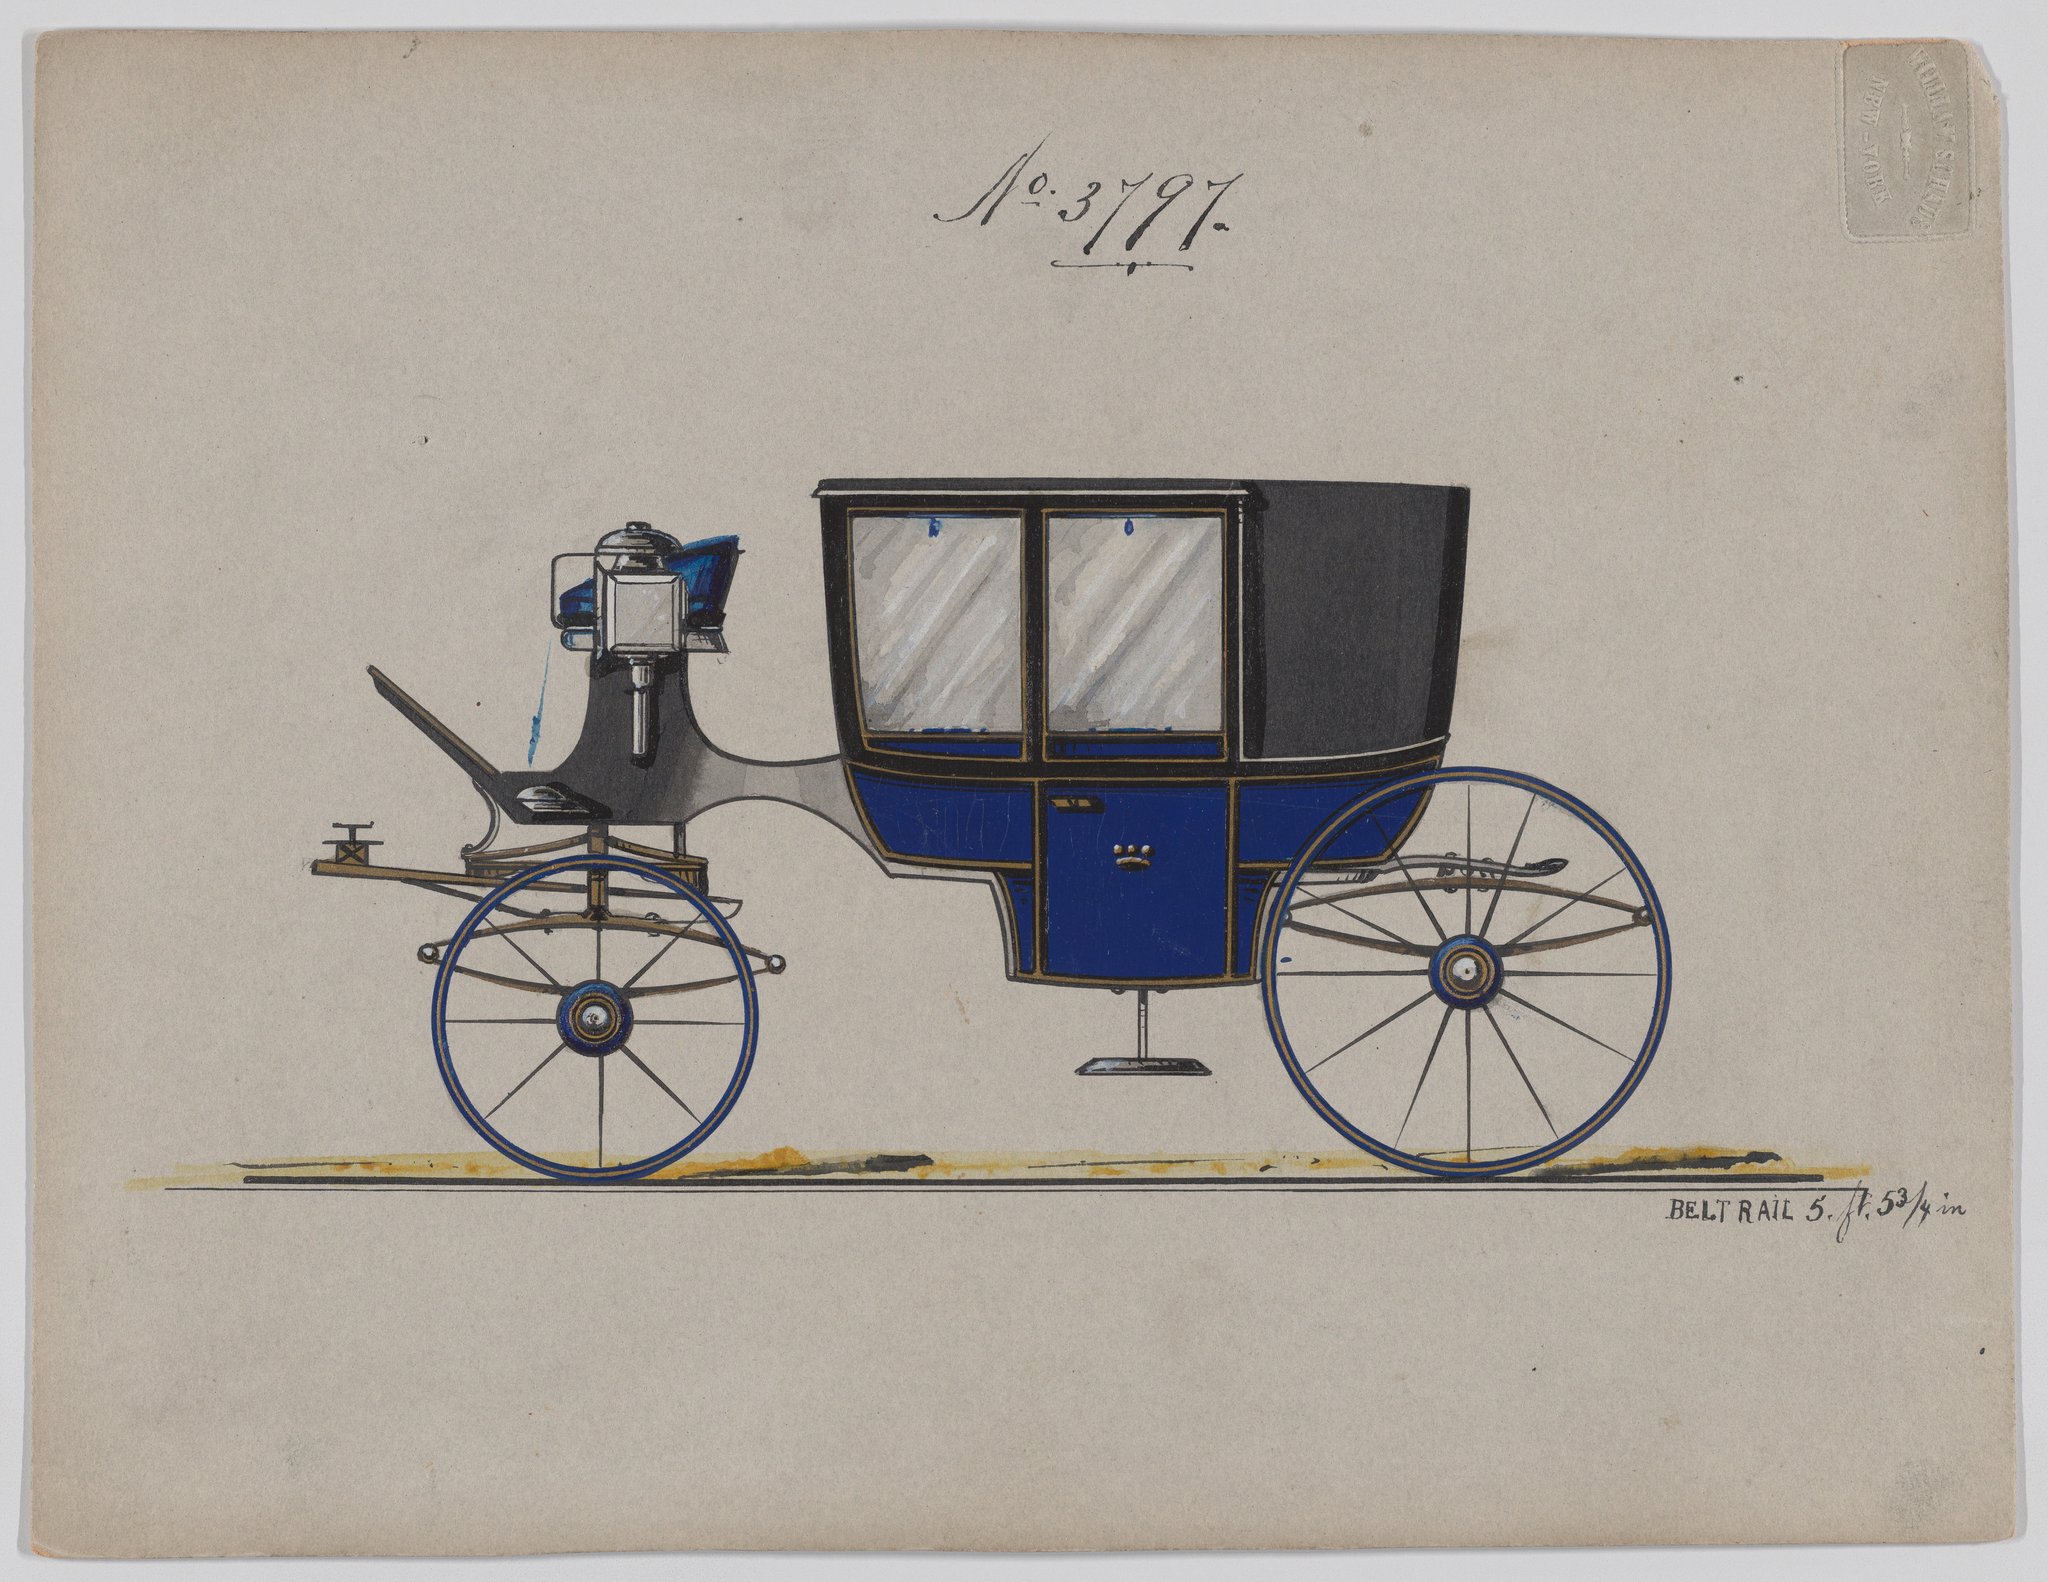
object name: drawing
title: Coach #3797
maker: brewster & co.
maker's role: manufacturer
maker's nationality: american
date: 1883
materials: gouache, gum arabic, ink, watercolor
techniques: pen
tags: carriages